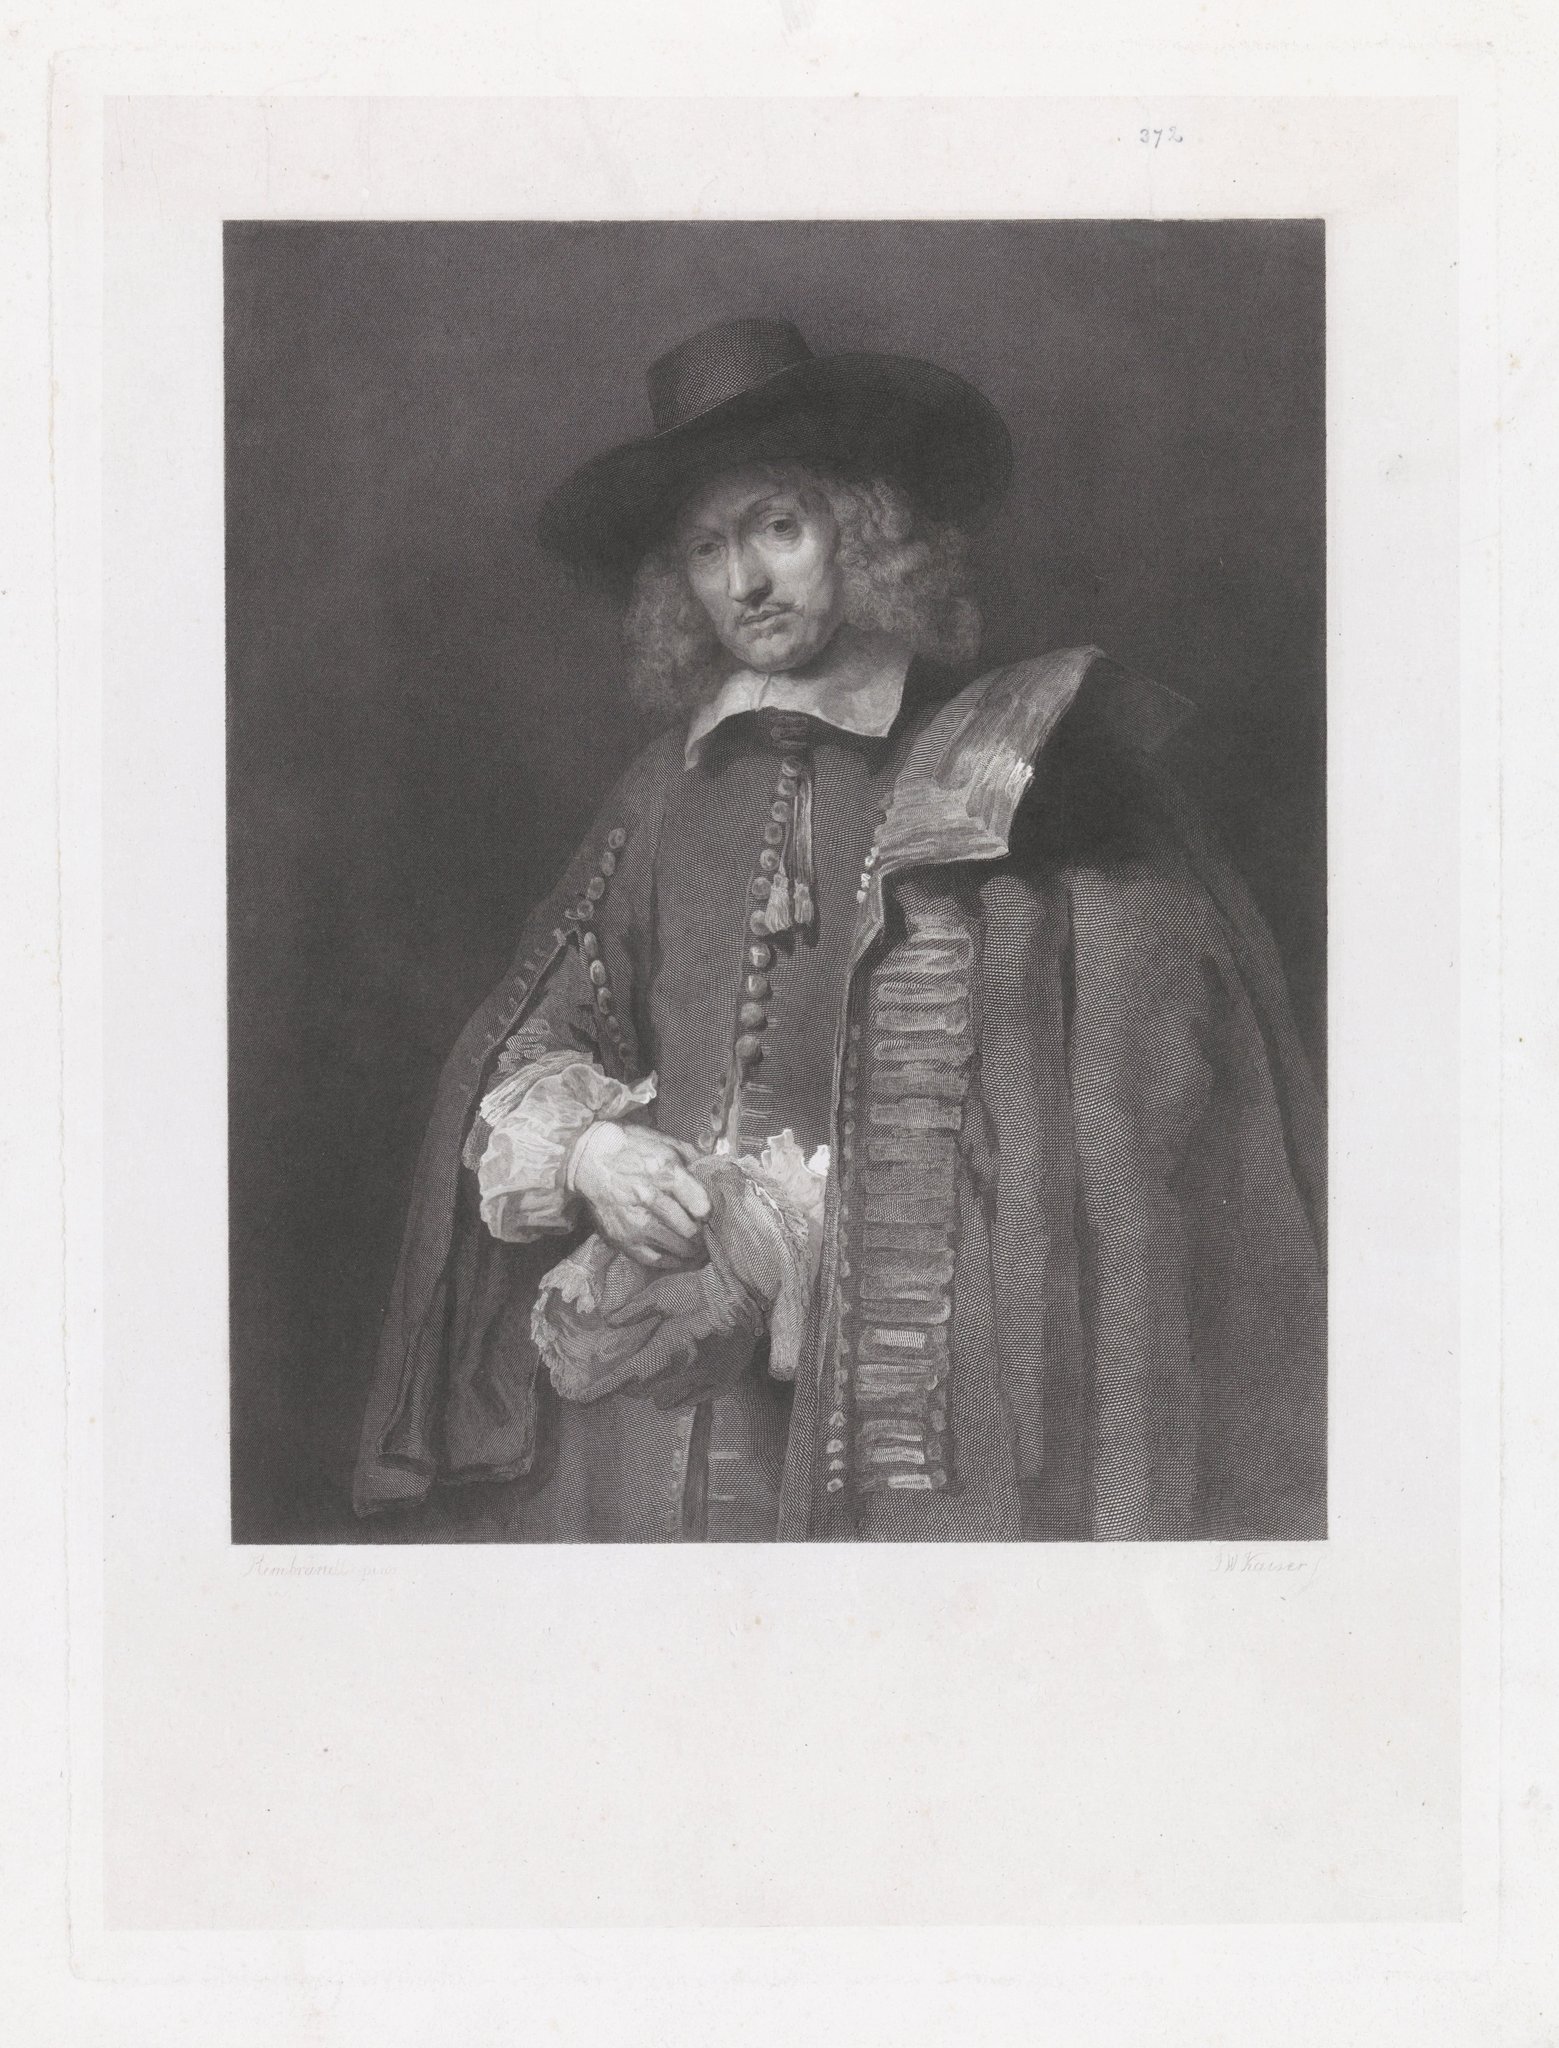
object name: print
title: Portret van Jan Six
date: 1823-1853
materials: paper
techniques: engraving, etching, roulette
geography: amsterdam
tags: amsterdam, mayor, jan six (1618-1700)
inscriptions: collector's mark: ‘François Buffa & Fils Amsterdam’, collector's mark: Lugt 2228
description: Portret ten halven lijve van Jan Six, burgemeester van Amsterdam.